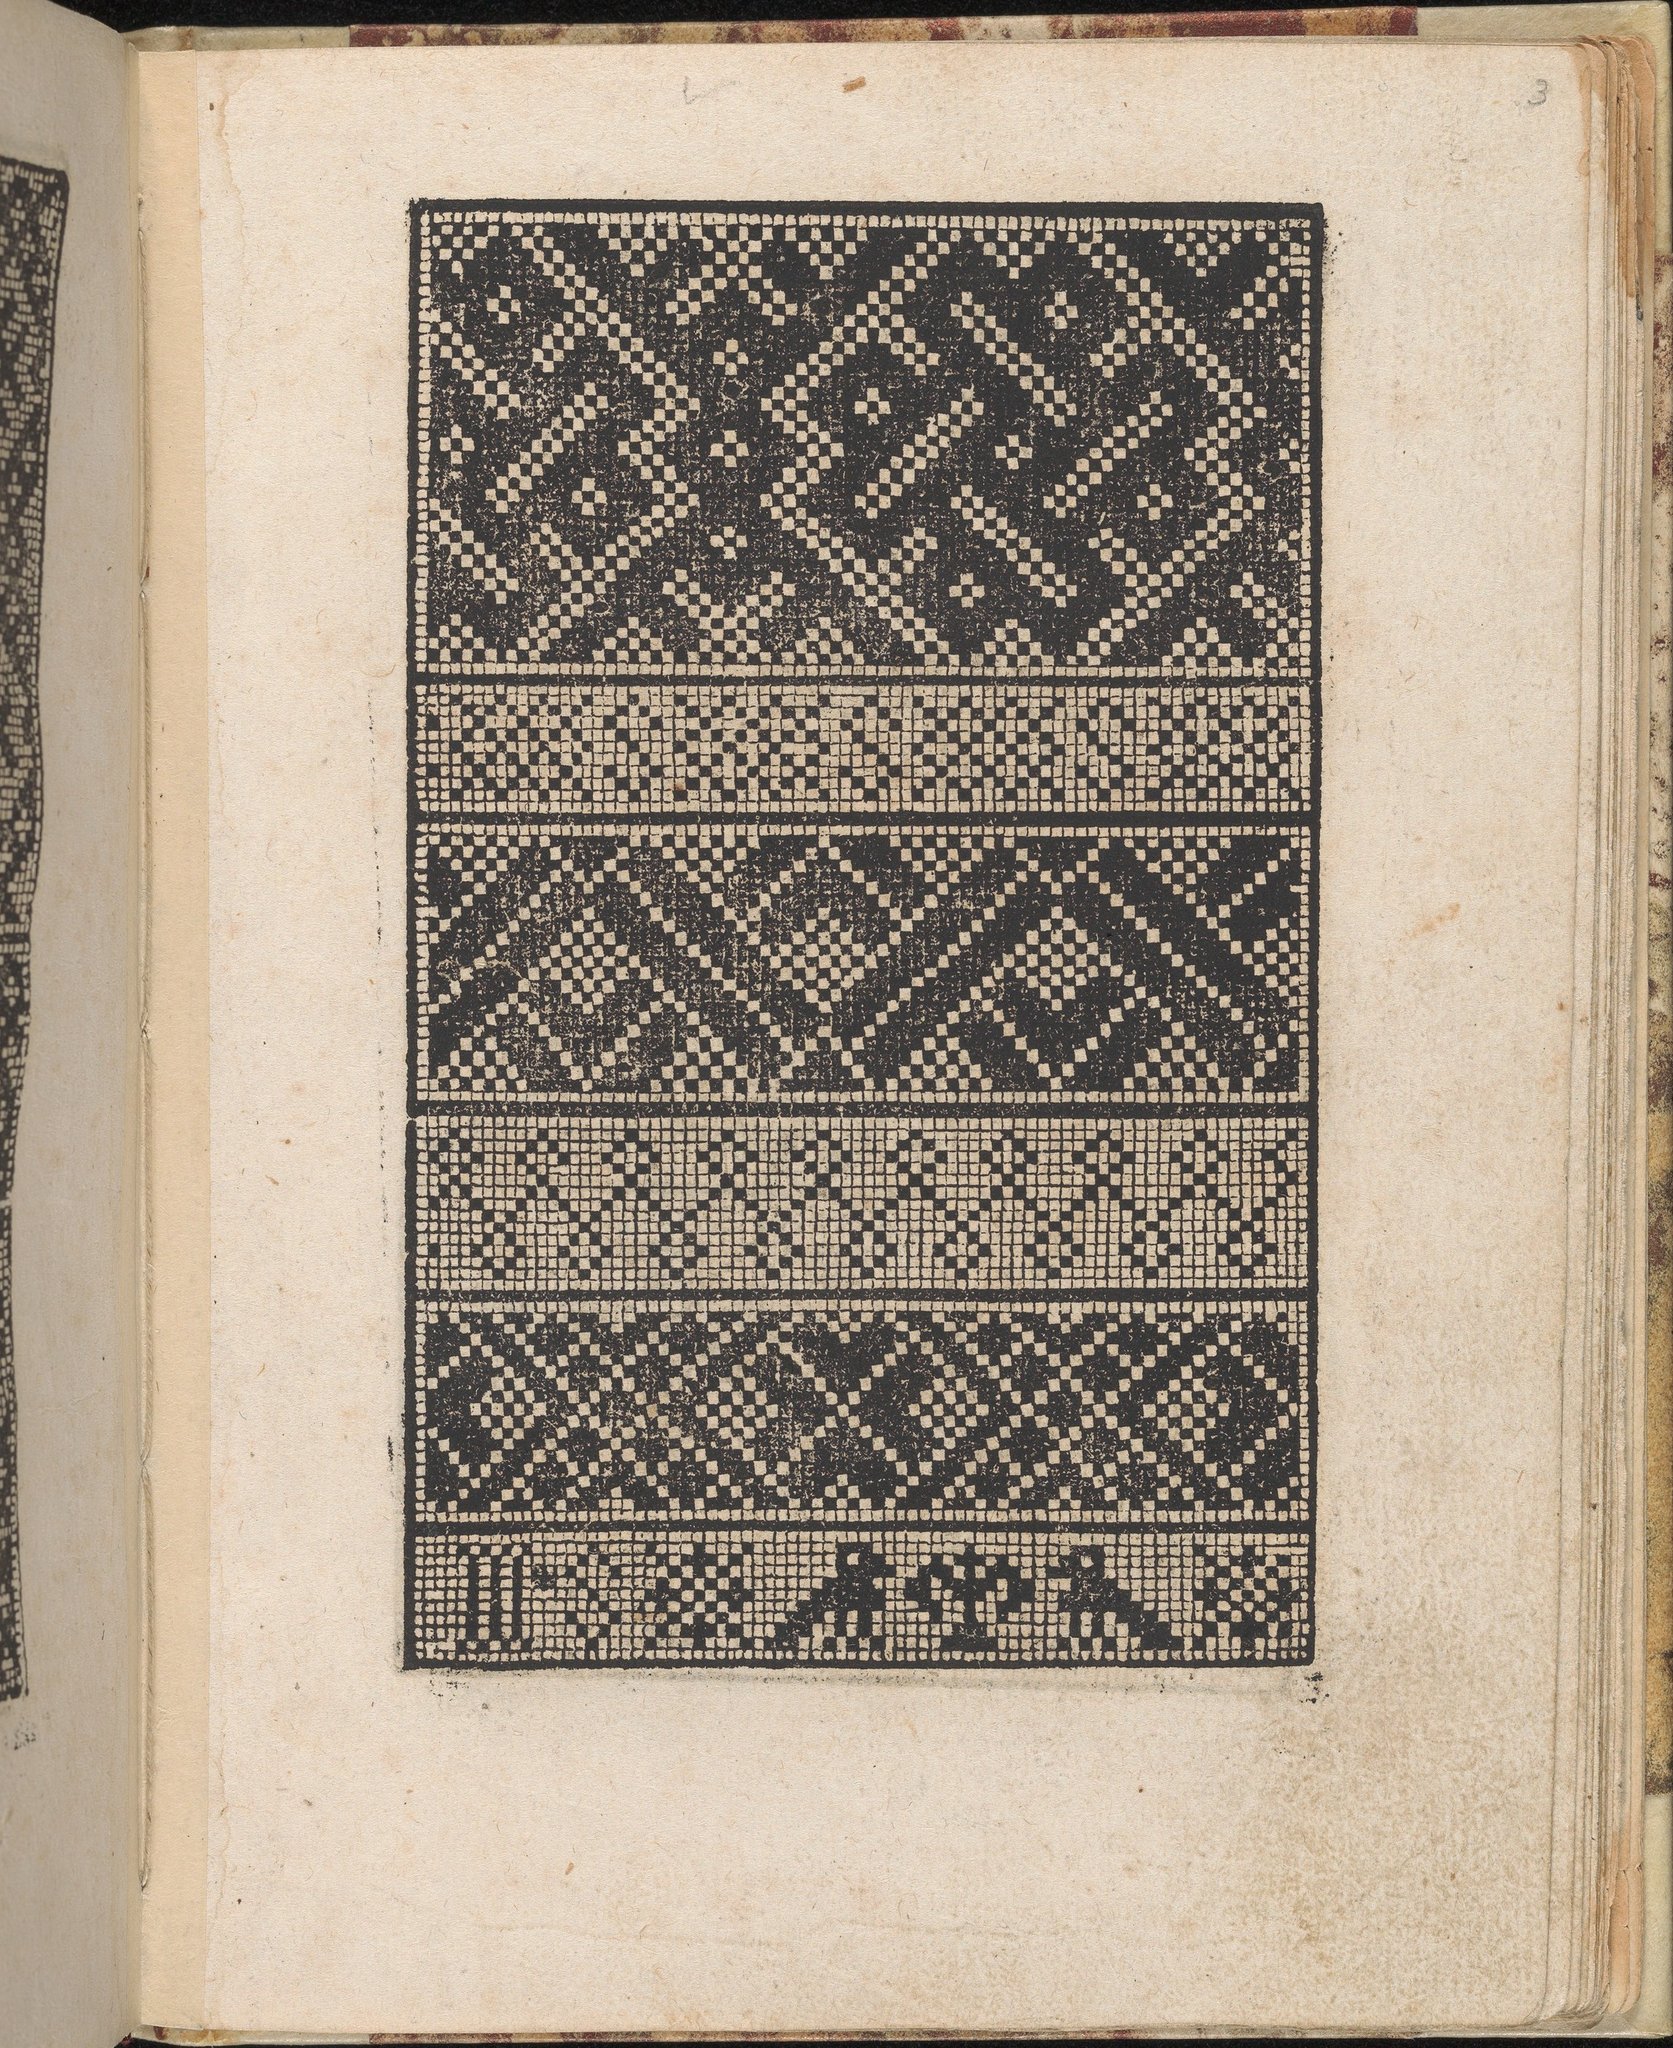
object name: book print ornament architecture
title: Ein new getruckt model Büchli...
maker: johann schönsperger the younger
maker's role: publisher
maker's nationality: german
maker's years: 1490-1550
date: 1529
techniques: printing, woodcut